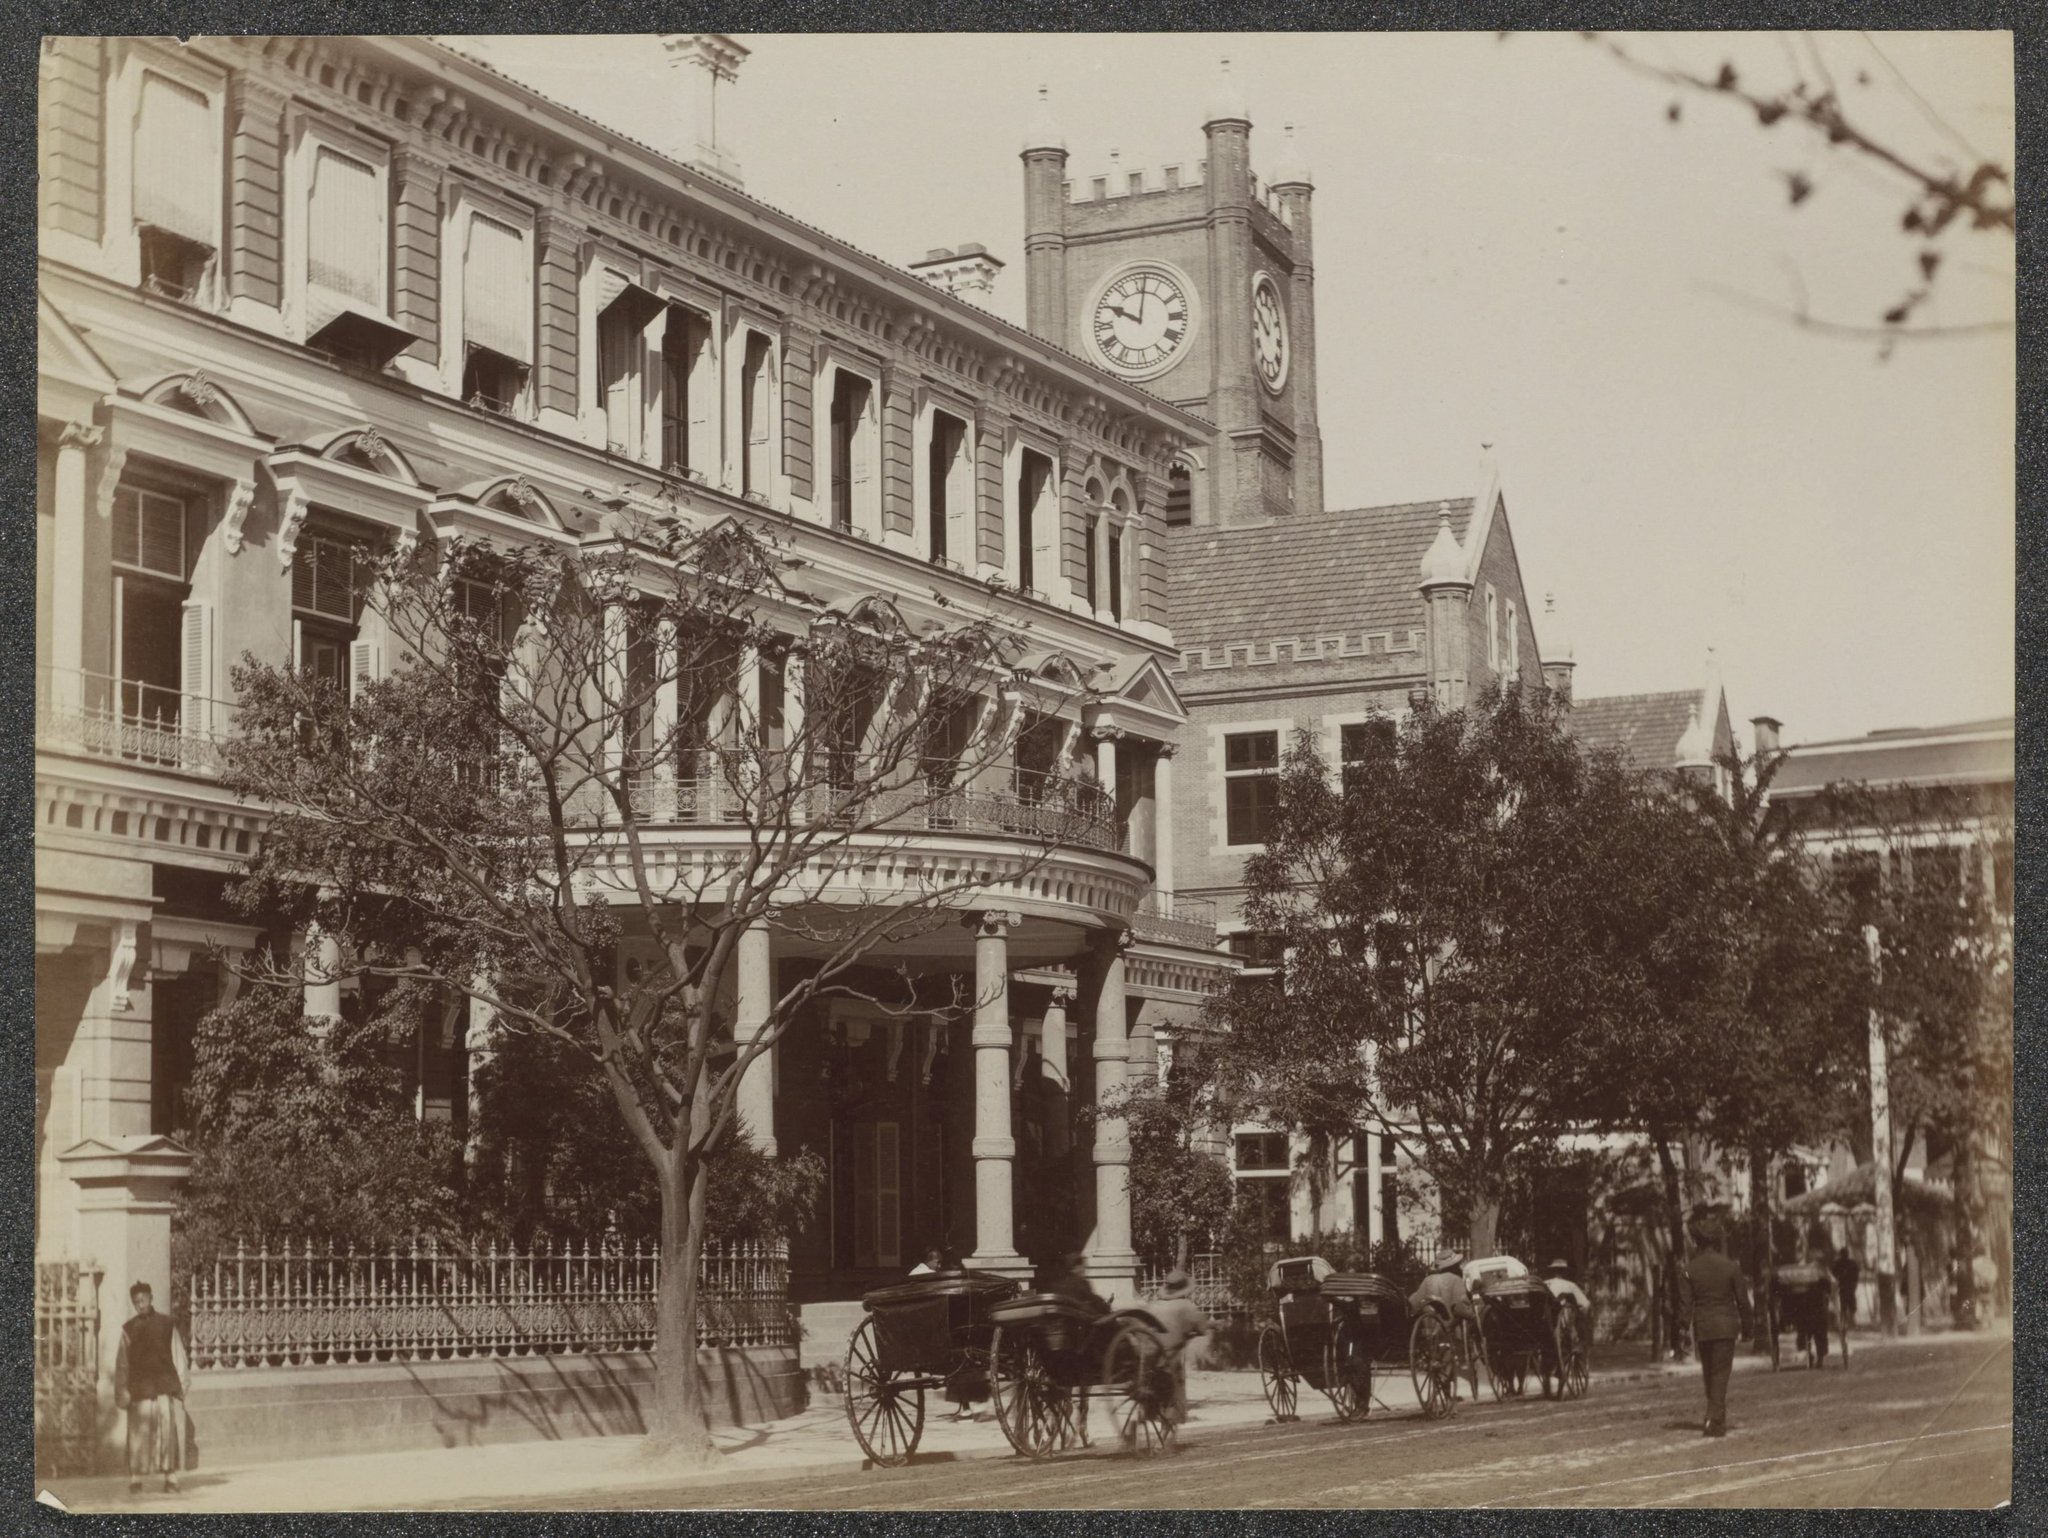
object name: photograph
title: Exterieur van de Hong Kong-Shanghai Bank aan de Bund in Shanghai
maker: Anonymous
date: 1860-1900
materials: paper, photographic support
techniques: albumen print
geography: shanghai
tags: exterior ~ representation of a building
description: Onderdeel van Album met 50 foto's van een reis door Zuidoost-Azië.